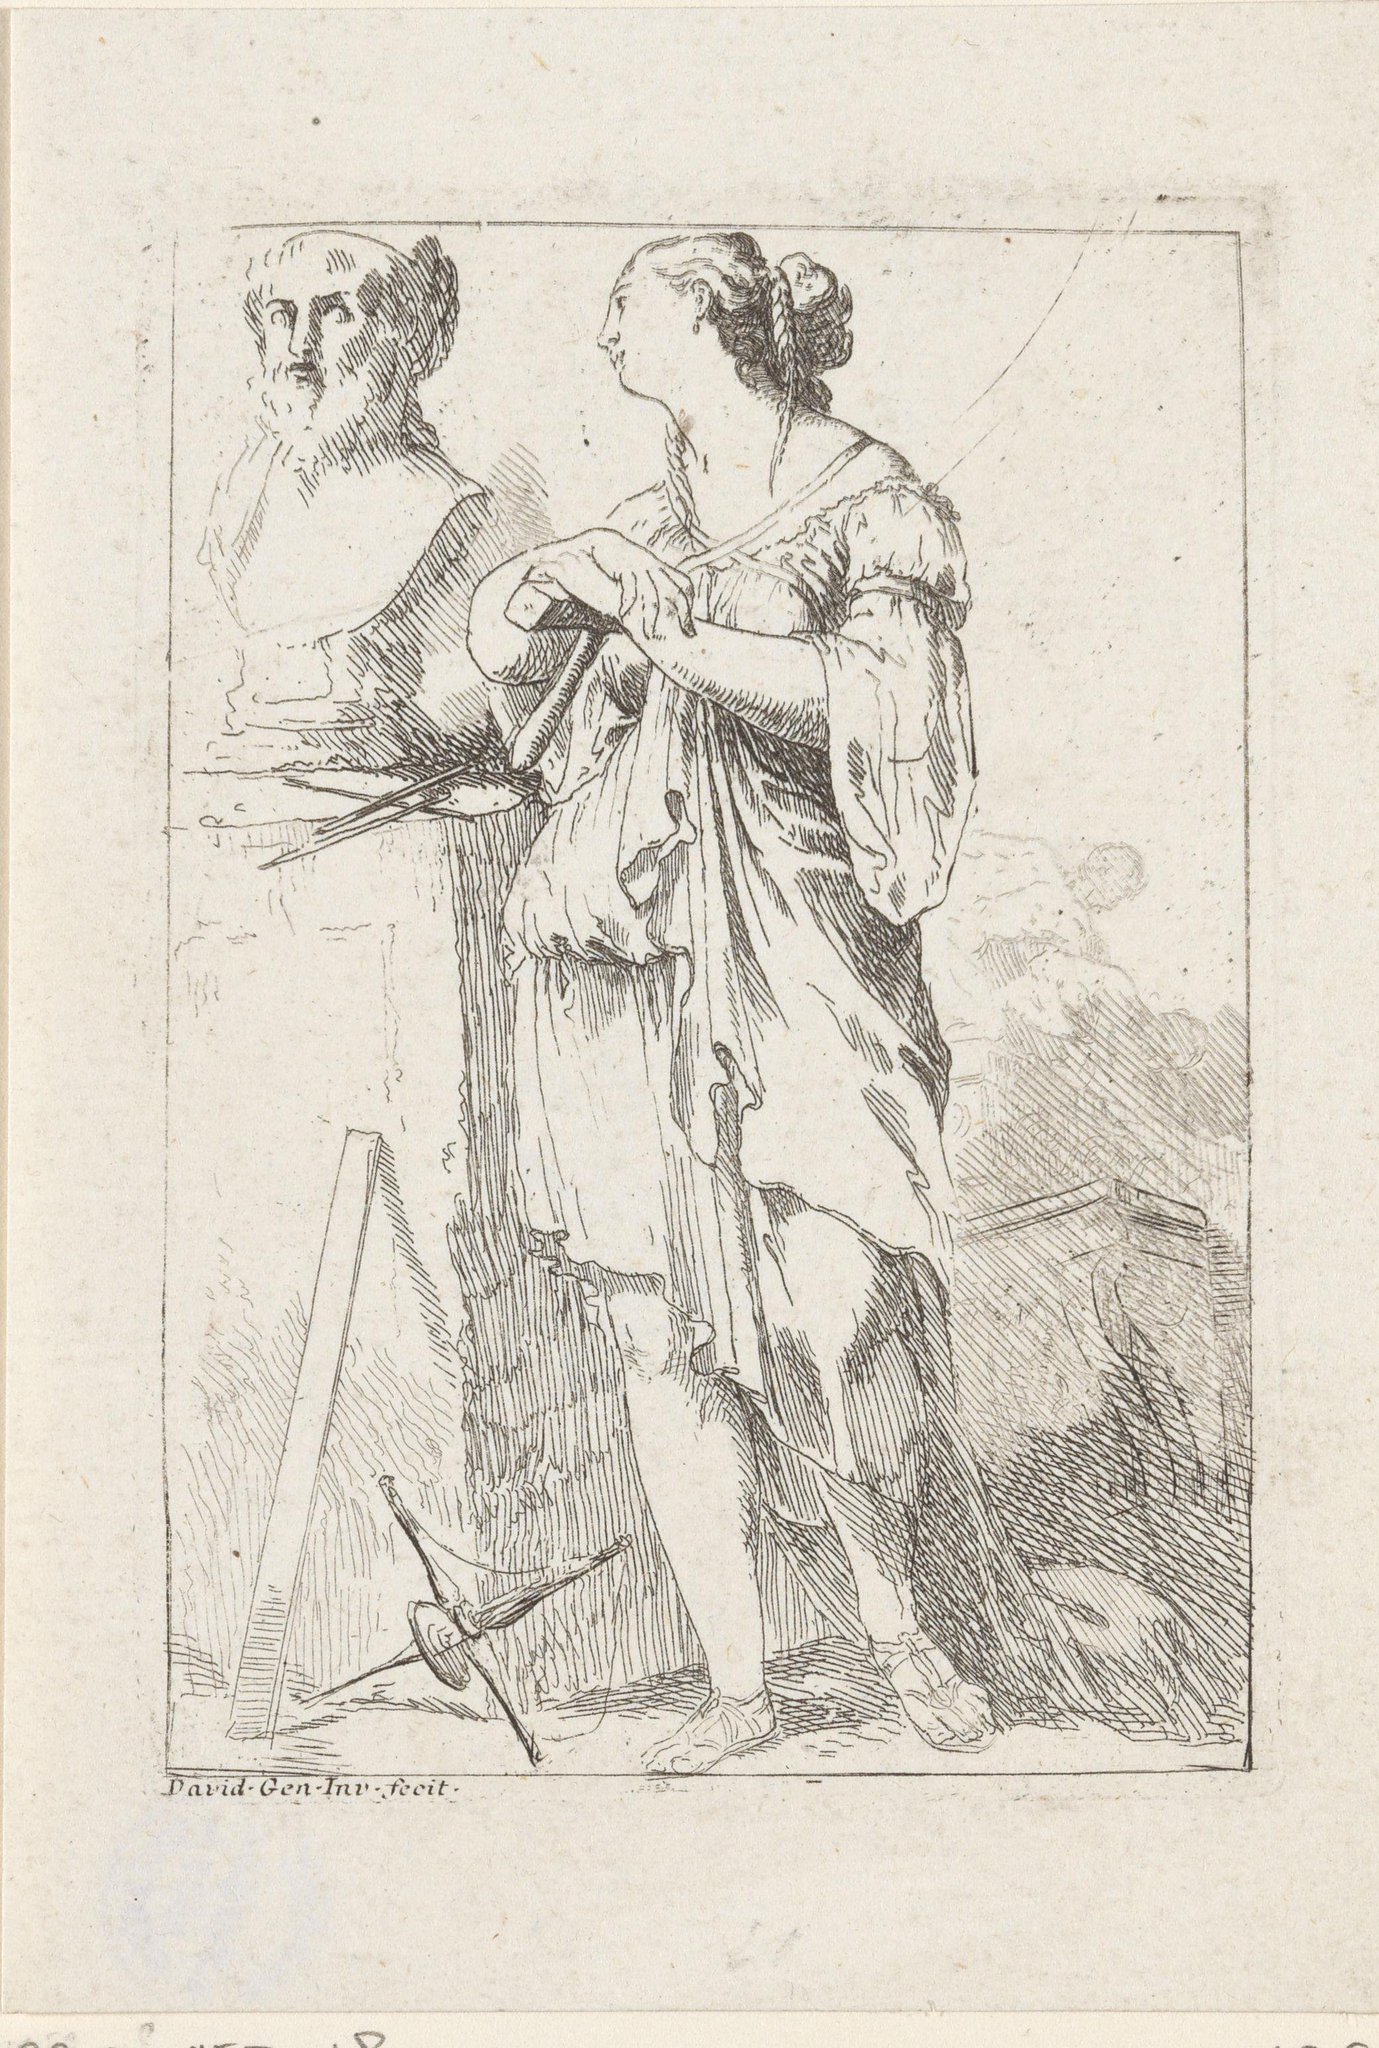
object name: print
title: Allegorie op de sculptuur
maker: giovanni david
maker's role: print maker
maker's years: 1743-1790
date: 1753-1790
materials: paper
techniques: etching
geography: italy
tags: 'sculptura', symbolic representations, allegories and emblems ~ sculpture; 'scoltura' (ripa), piece of sculpture, reproduction of a piece of sculpture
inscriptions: collector's mark: Lugt 2228, collector's mark: ‘... par le centrale’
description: Allegorie op de sculptuur. Een vrouwelijke figuur met een hamer naast een gebeeldhouwde buste.